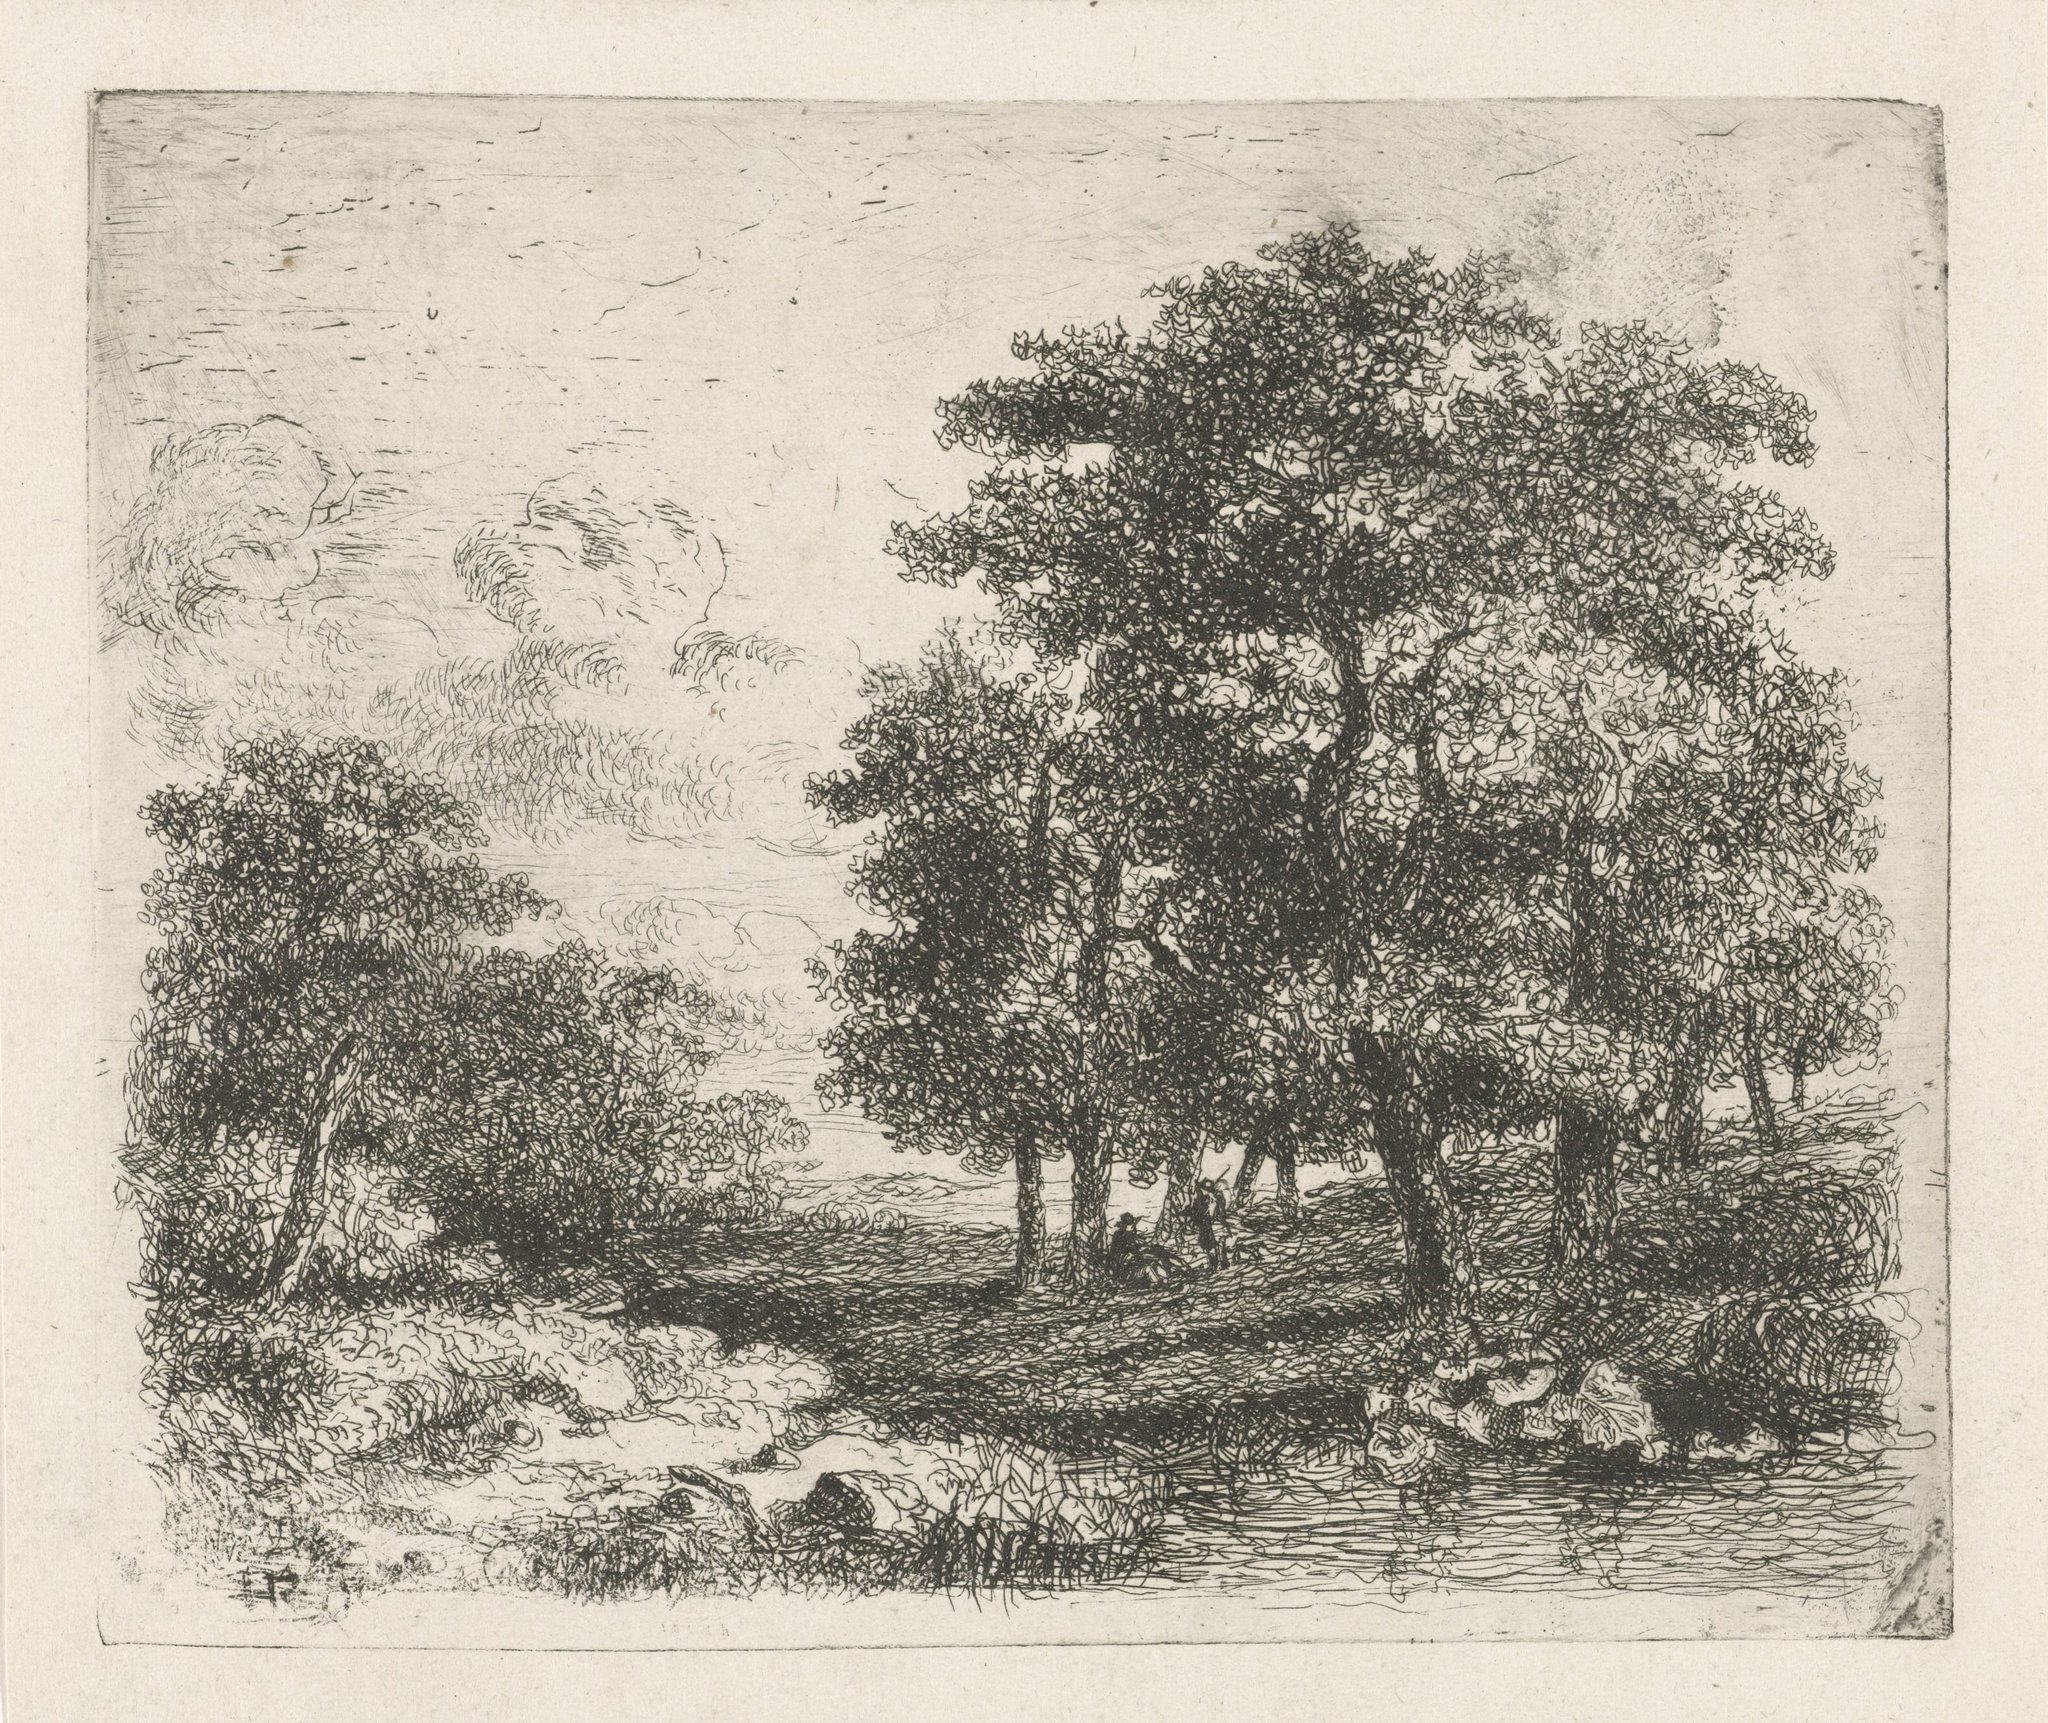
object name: print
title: Boomrijk landschap met twee converserende mannen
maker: hermanus jan hendrik van rijkelijkhuysen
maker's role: painter, print maker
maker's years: 1813-1883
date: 1823-1883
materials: paper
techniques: drypoint, etching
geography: utrecht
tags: swamp, inland marsh, fens (+ landscape with figures, staffage), trees, conversation, dialogue; conversation piece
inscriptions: collector's mark: Lugt 2228